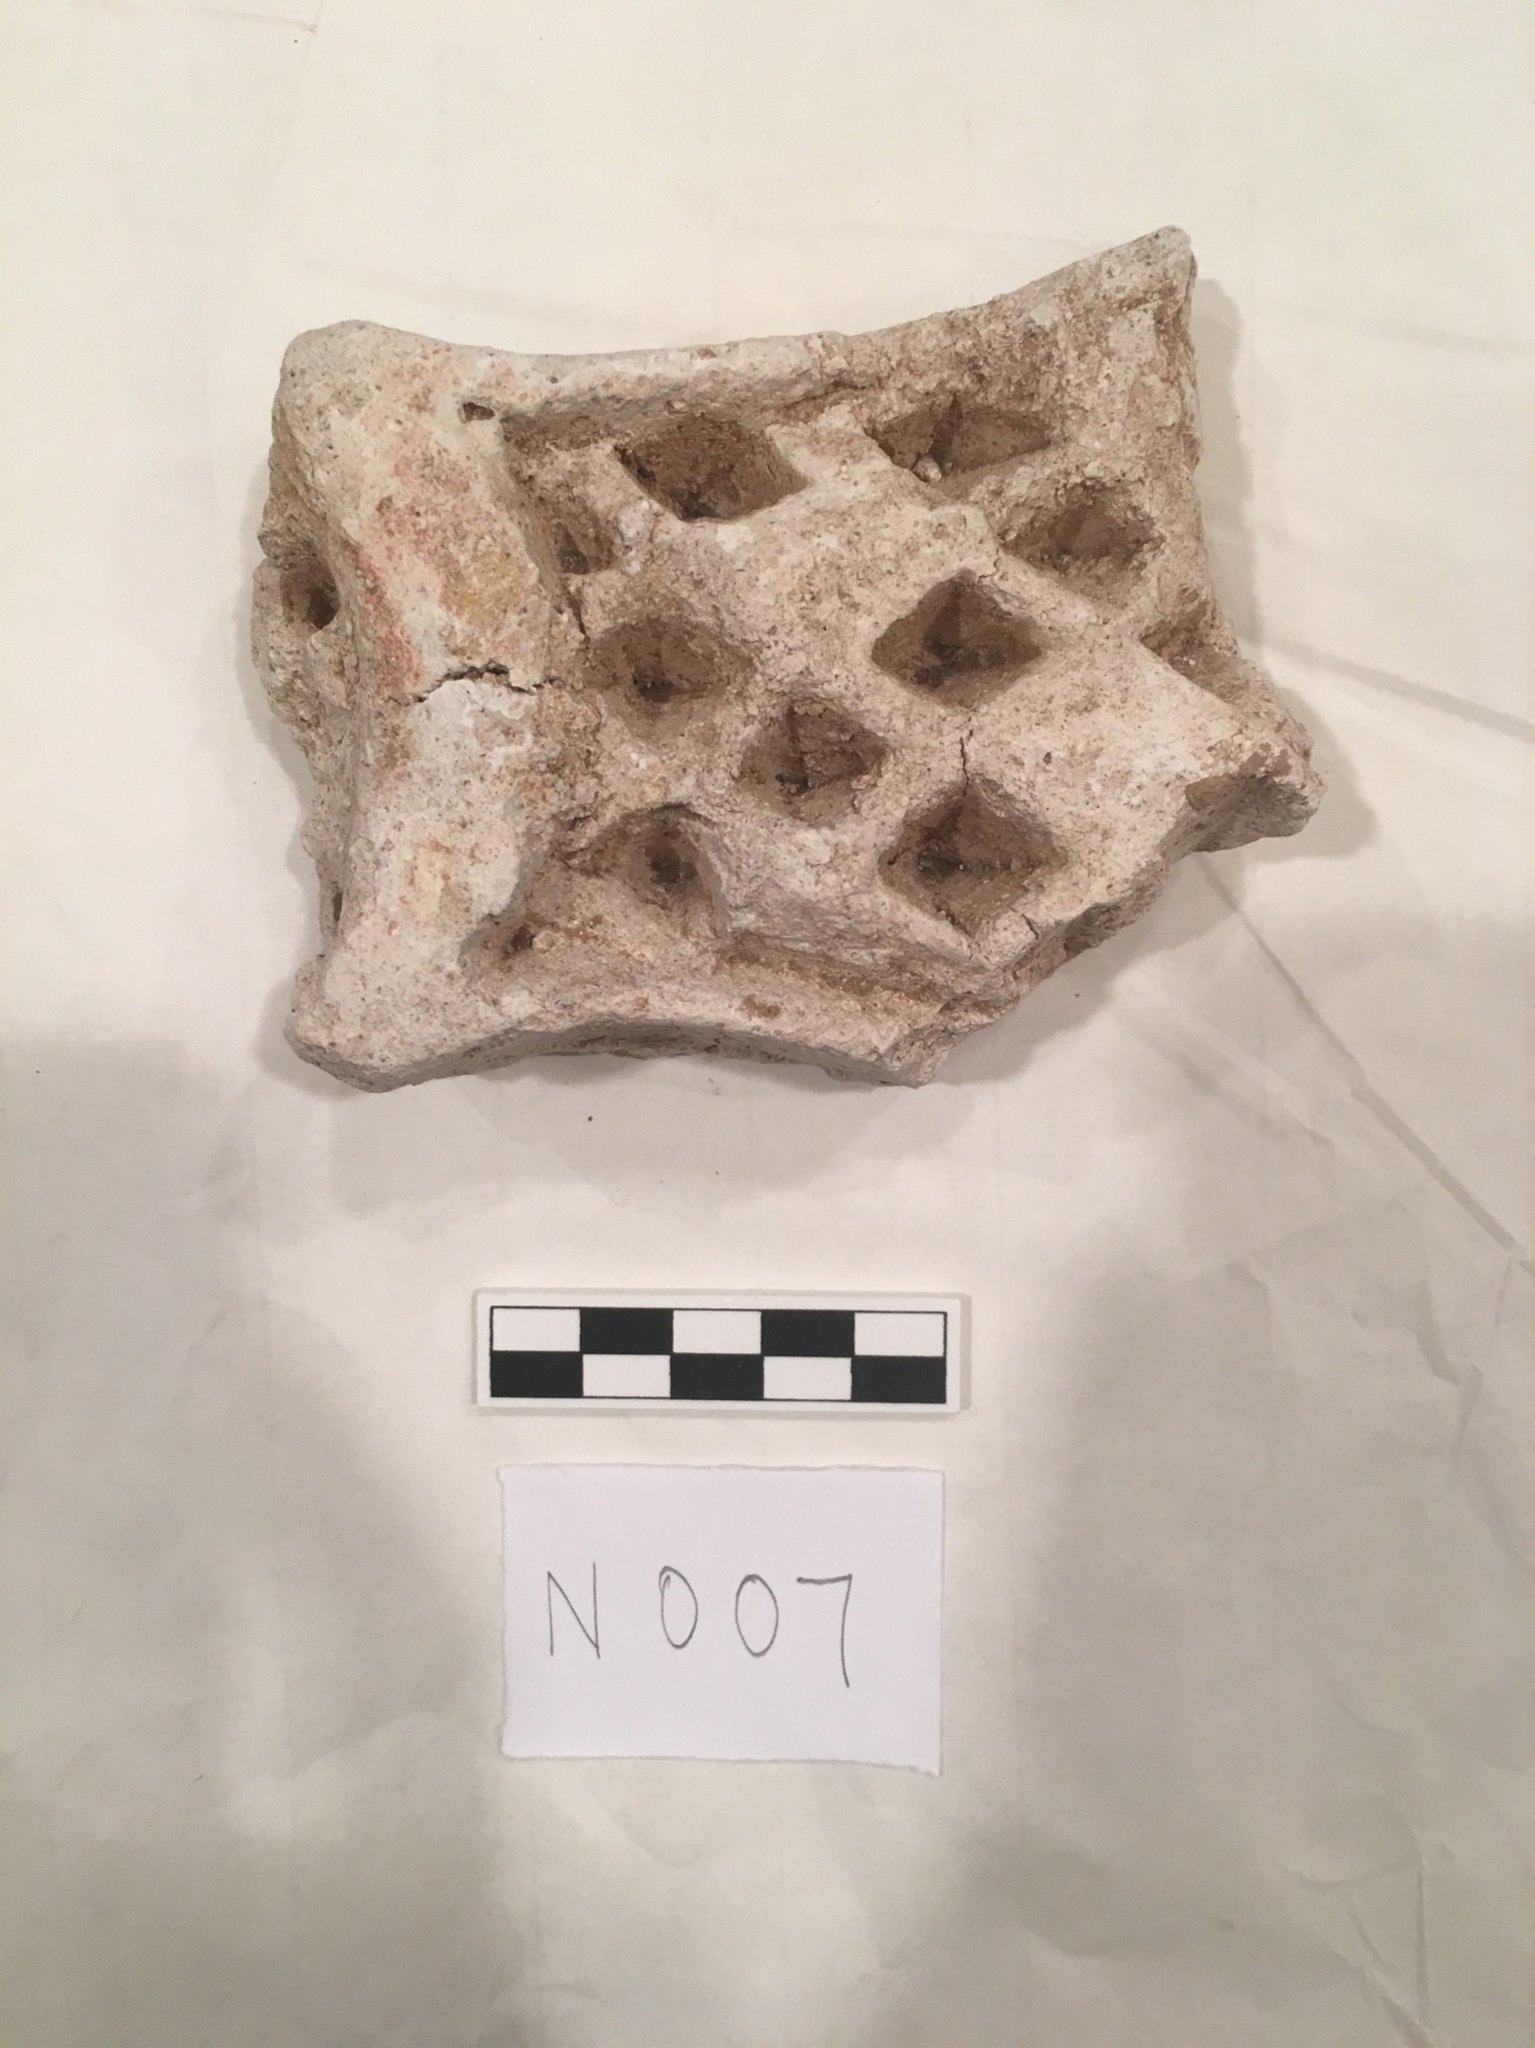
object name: fragment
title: Stucco Fragment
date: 701-1200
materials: plaster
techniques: carving, painting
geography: iran